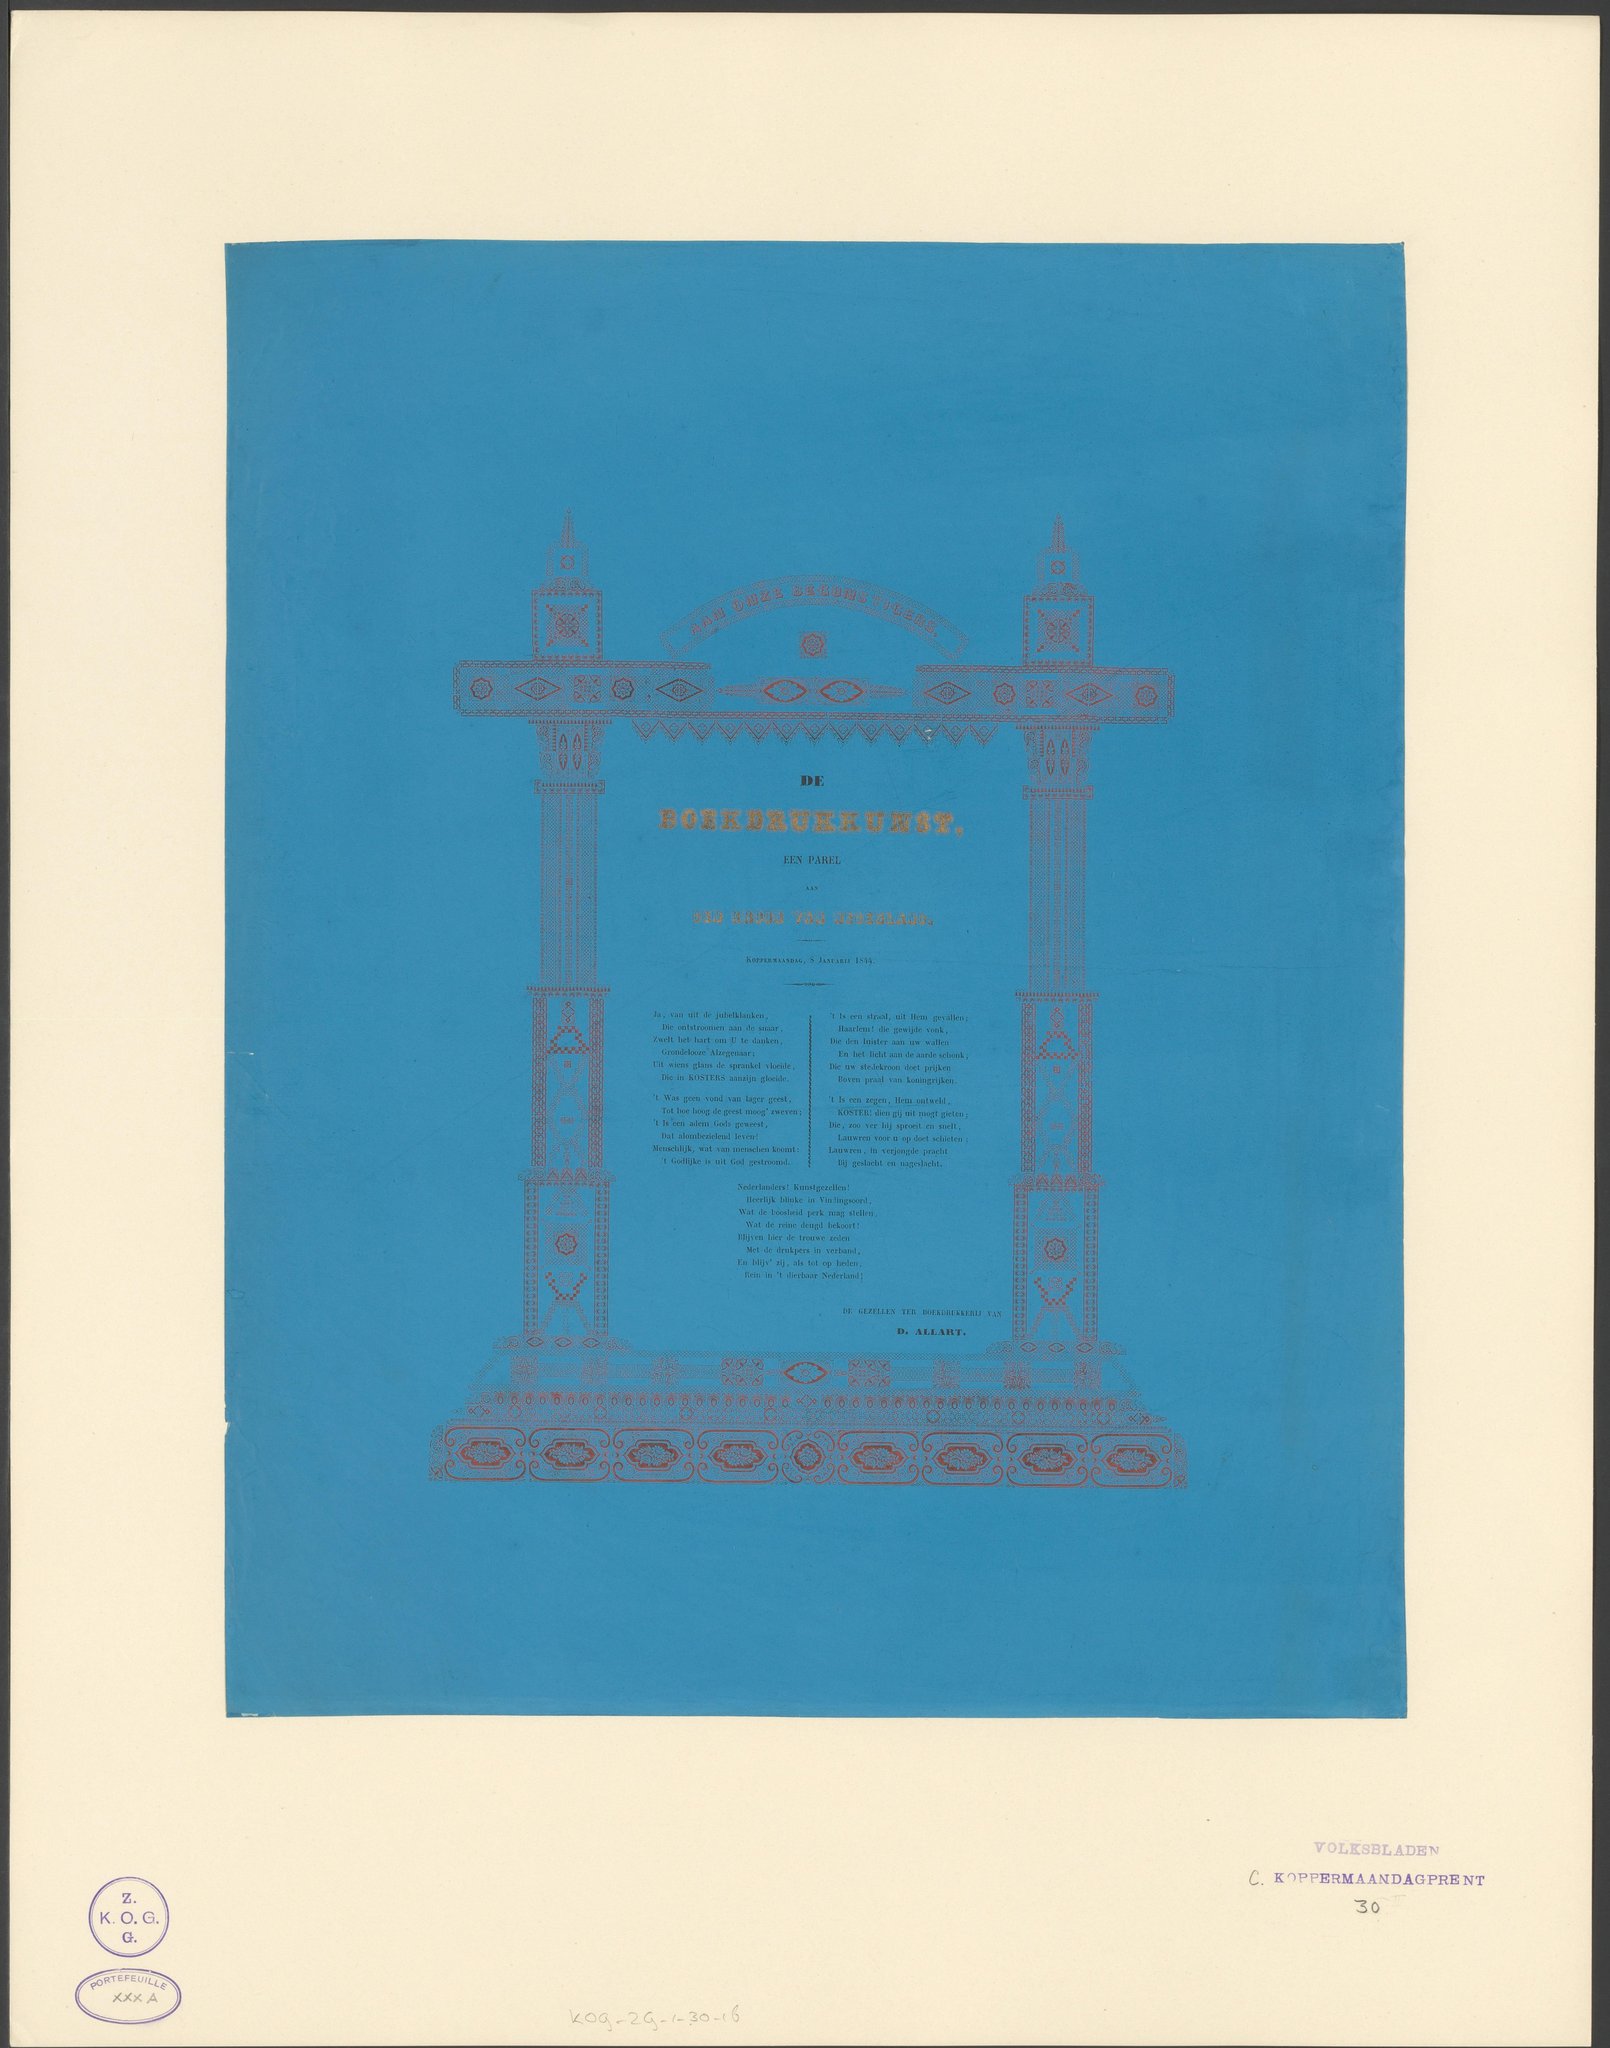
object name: koppermaandagprent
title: Koppermaandagprent met een lofzang op de boekdrukkunst, 1844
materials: paper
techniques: letterpress printing, printing block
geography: amsterdam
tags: 'blue monday'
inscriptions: collector's mark: Lugt 1641, stamp, stamp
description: Koppermaandagprent door de gezellen van de boekdrukkerij van Dirk Allart te Amsterdam, ter gelegenheid van Koppermaandag 8 januari 1844. In het midden een vers in twee kolommen namens de gezellen. Onderwerpsrubrieken binnen de Atlas Zeden en Gewoonten: Zeden en Gewoonten in engeren zin. Volksleven. Volksbladen. Koppermaandagwenschen.